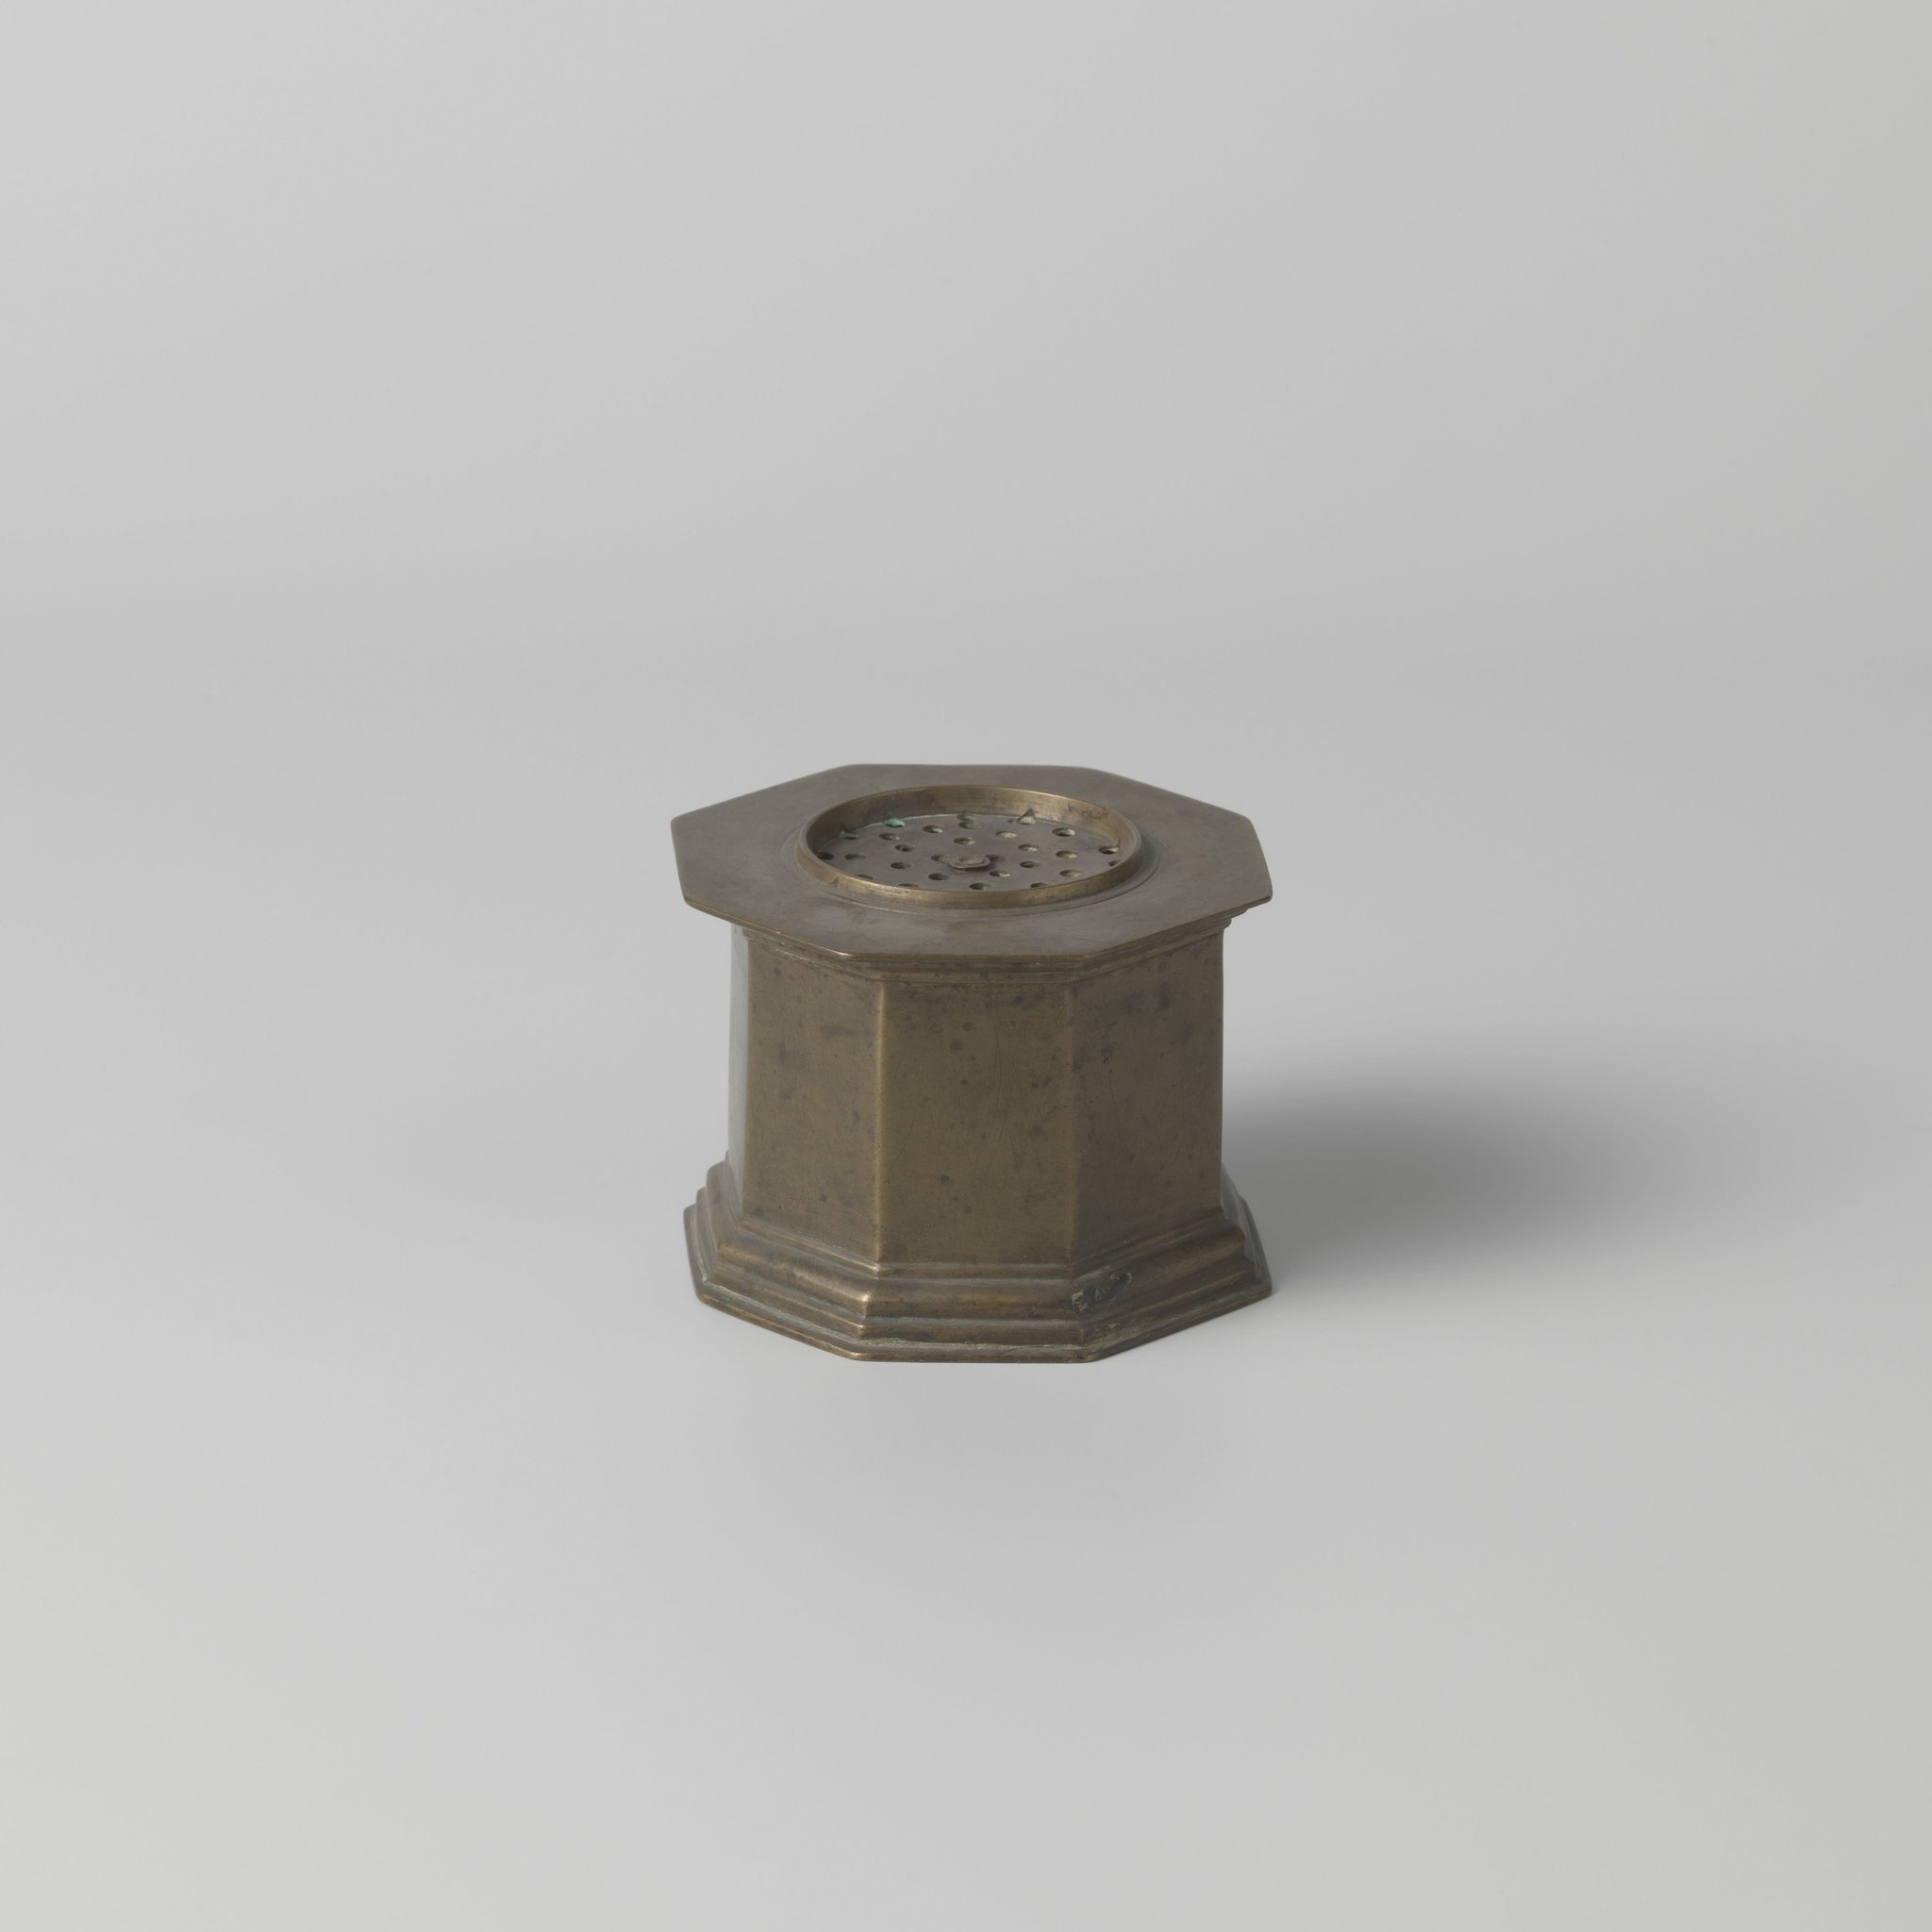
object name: sander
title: Zandstrooier van messing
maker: Anonymous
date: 1600-1699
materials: brass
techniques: casting, woodworking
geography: western europe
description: Het achtkantige voorwerp heeft een wand, die uit verticale rechte vlakken is opgebouw, welke boven en onder is afgezet met een uitstekende profilering. Bovenop zijn in het ronde door een rand omgeven gedeelte strooigaten geboord. De onderkant van het voorwerp is met gegroefde ringen versierd.